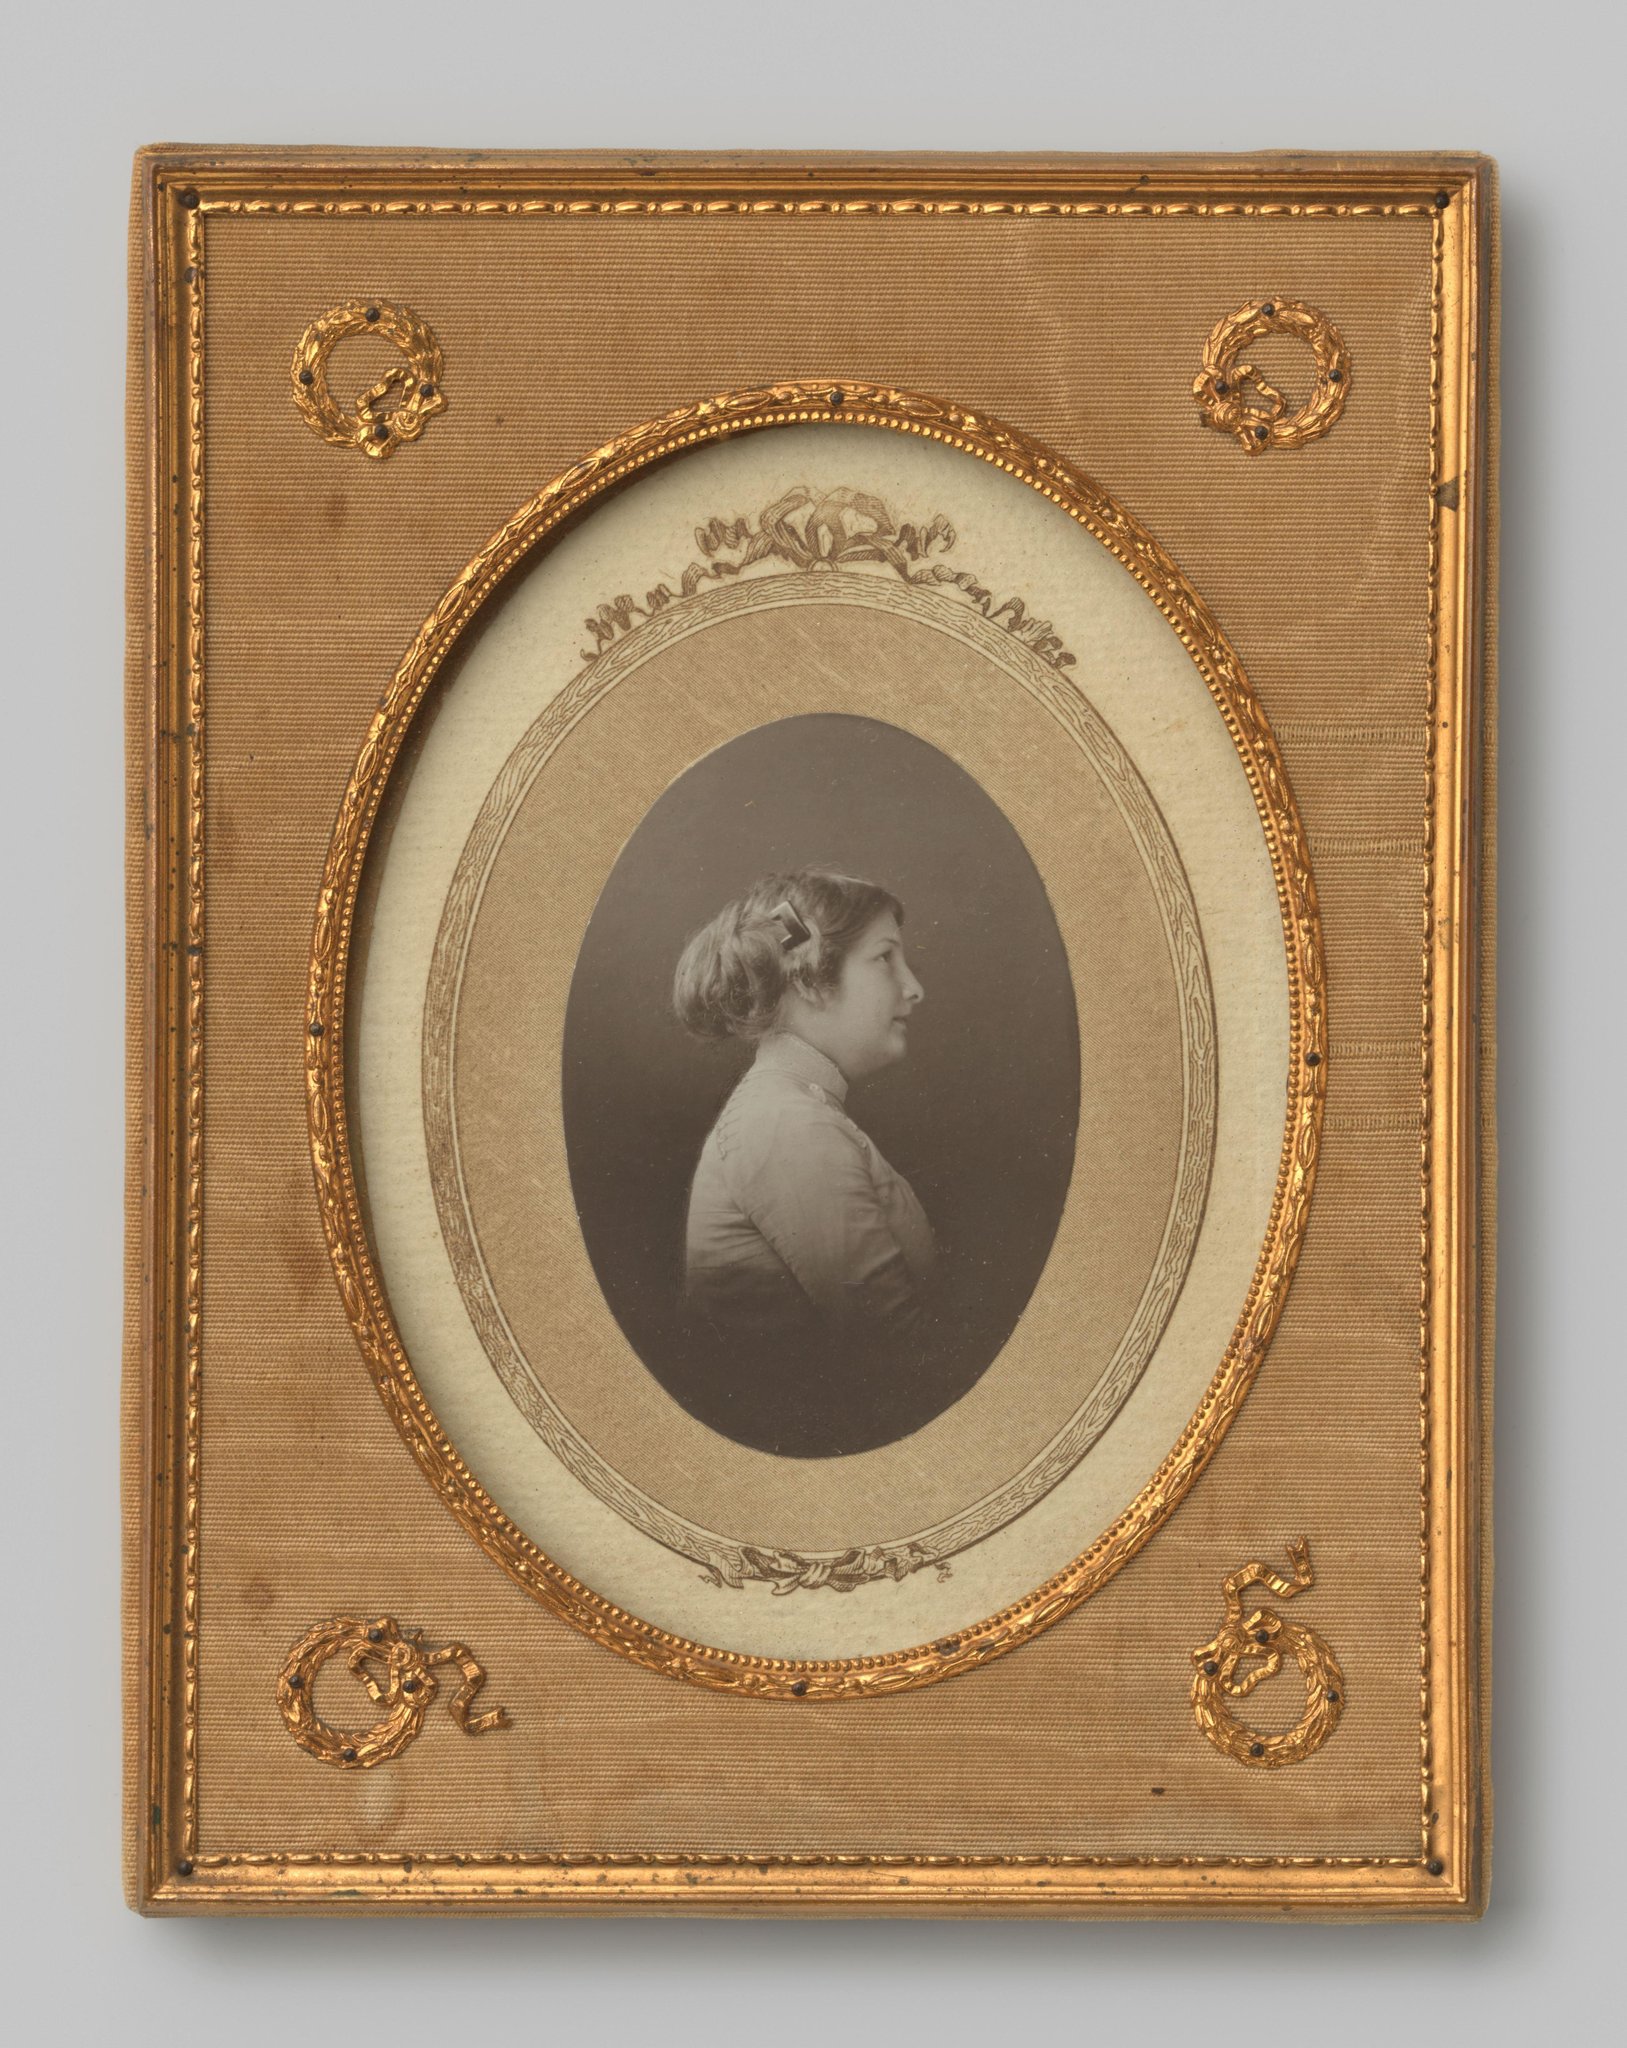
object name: photograph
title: Portret van een onbekende vrouw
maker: Anonymous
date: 1880-1900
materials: paper, cardboard, glass, metal, textile, wood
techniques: gelatin silver print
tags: adult woman, anonymous historical person portrayed